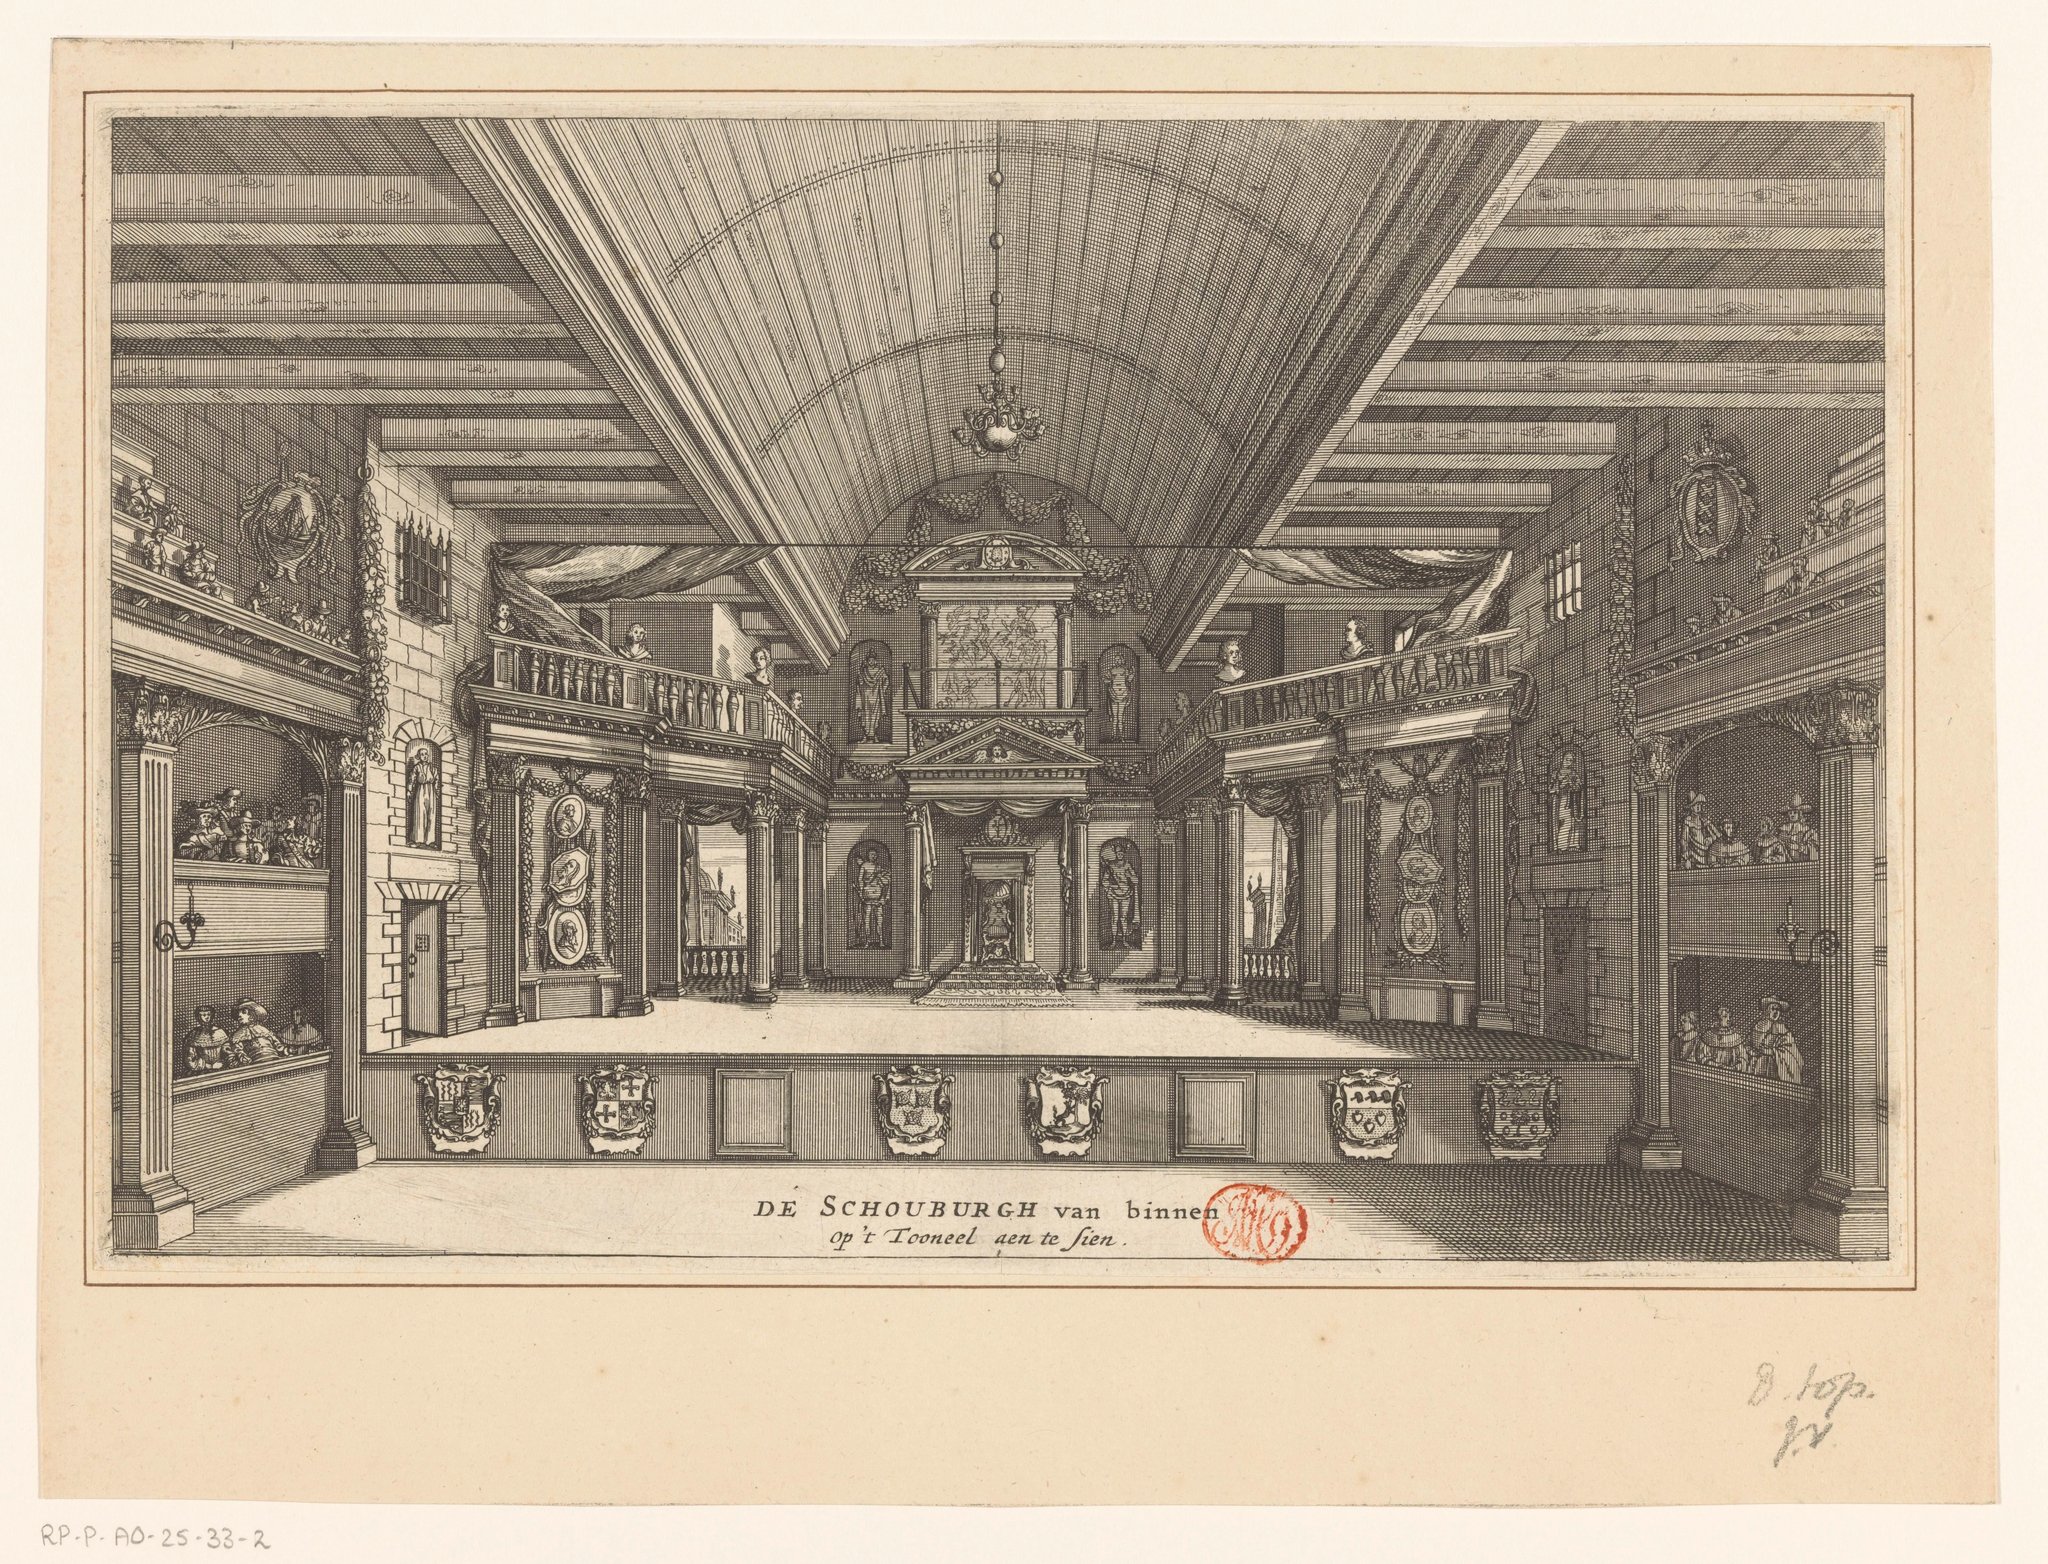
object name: print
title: De Schouburgh van binnen op 't tooneel aen te sien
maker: jacob van meurs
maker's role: draughtsman, print maker, publisher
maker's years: 1619-1680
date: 1663-1664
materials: paper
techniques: engraving, etching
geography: amsterdam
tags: coat of arms (as symbol of the state, etc.) (+ city; municipal), theatre (building), the stage and its equipment, armorial bearing, heraldry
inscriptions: collector's mark: Lugt 195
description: Huidige staat van prent ook gebruikt in: Dapper, Olfert. Historische beschryving der stadt Amsterdam: waer in de voornaemste geschiedenissen (na een kort verhael van gansch Hollant en d'omleggende dorpen (…). Amsterdam: Jacob van Meurs, 1663.* En in: Zesen, Philipp von. Beschreibung der Stadt Amsterdam: darinnen von derselben ersten Ursprunge bis auf gegenwärtigen Zustand (…). Amsterdam: Joachim Nosche, 1664. * In sommige exemplaren van deze uitgave komt de huidige staat van de prent voor. In andere exemplaren is een latere staat ingebonden, waarop boven de Nederlandse een Franse titel is toegevoegd.